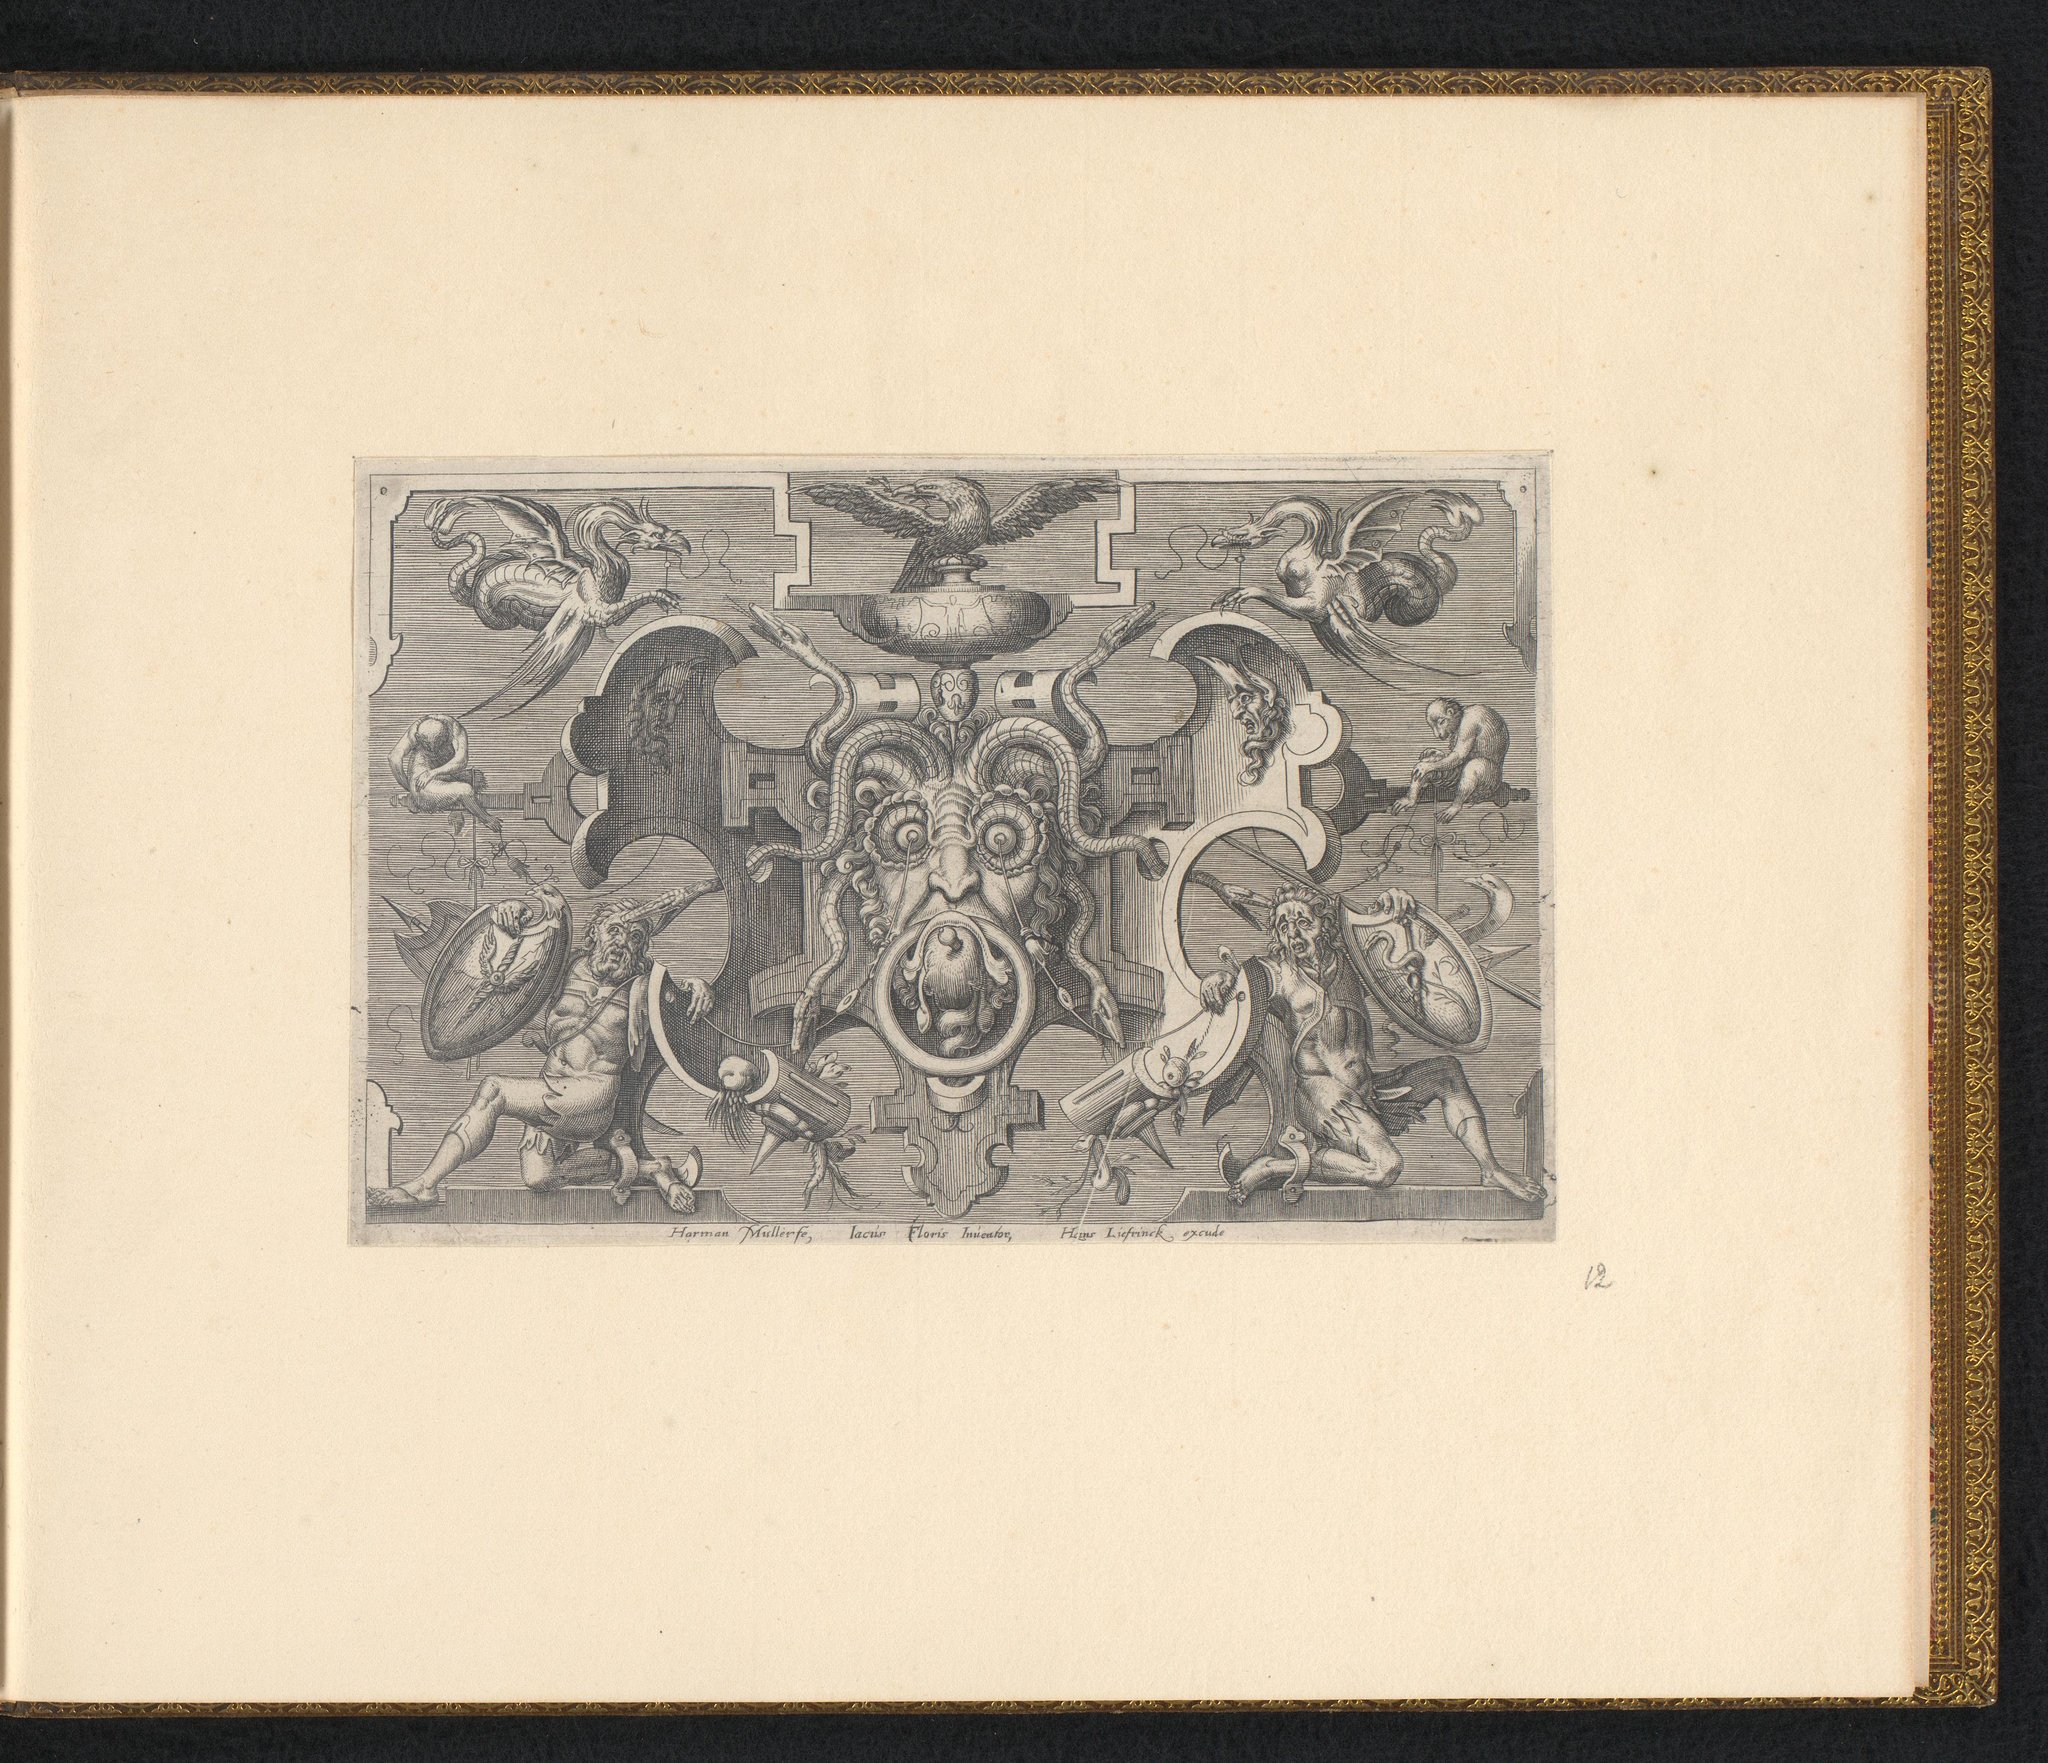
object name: ornament print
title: Cartouche en mascaron met slangen als haren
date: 1564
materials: paper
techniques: engraving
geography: antwerp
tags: snakes, predatory birds: eagle, scrollwork, strapwork ~ ornament, monkeys, apes, ornament ~ cartouche, mask, mascaron ~ ornament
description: Cartouche in een omlijsting van rolwerk. In het midden een mascaron met slangen als haren. Twee slangenkoppen vallen twee krijgers met wapenschilden aan. Boven de cartouche een adelaar op een vaas. Links en rechts daarvan een vliegende draak en twee apen. Onderaan twee geknielde krijgers met een schild. De prent maakt deel uit van een album.